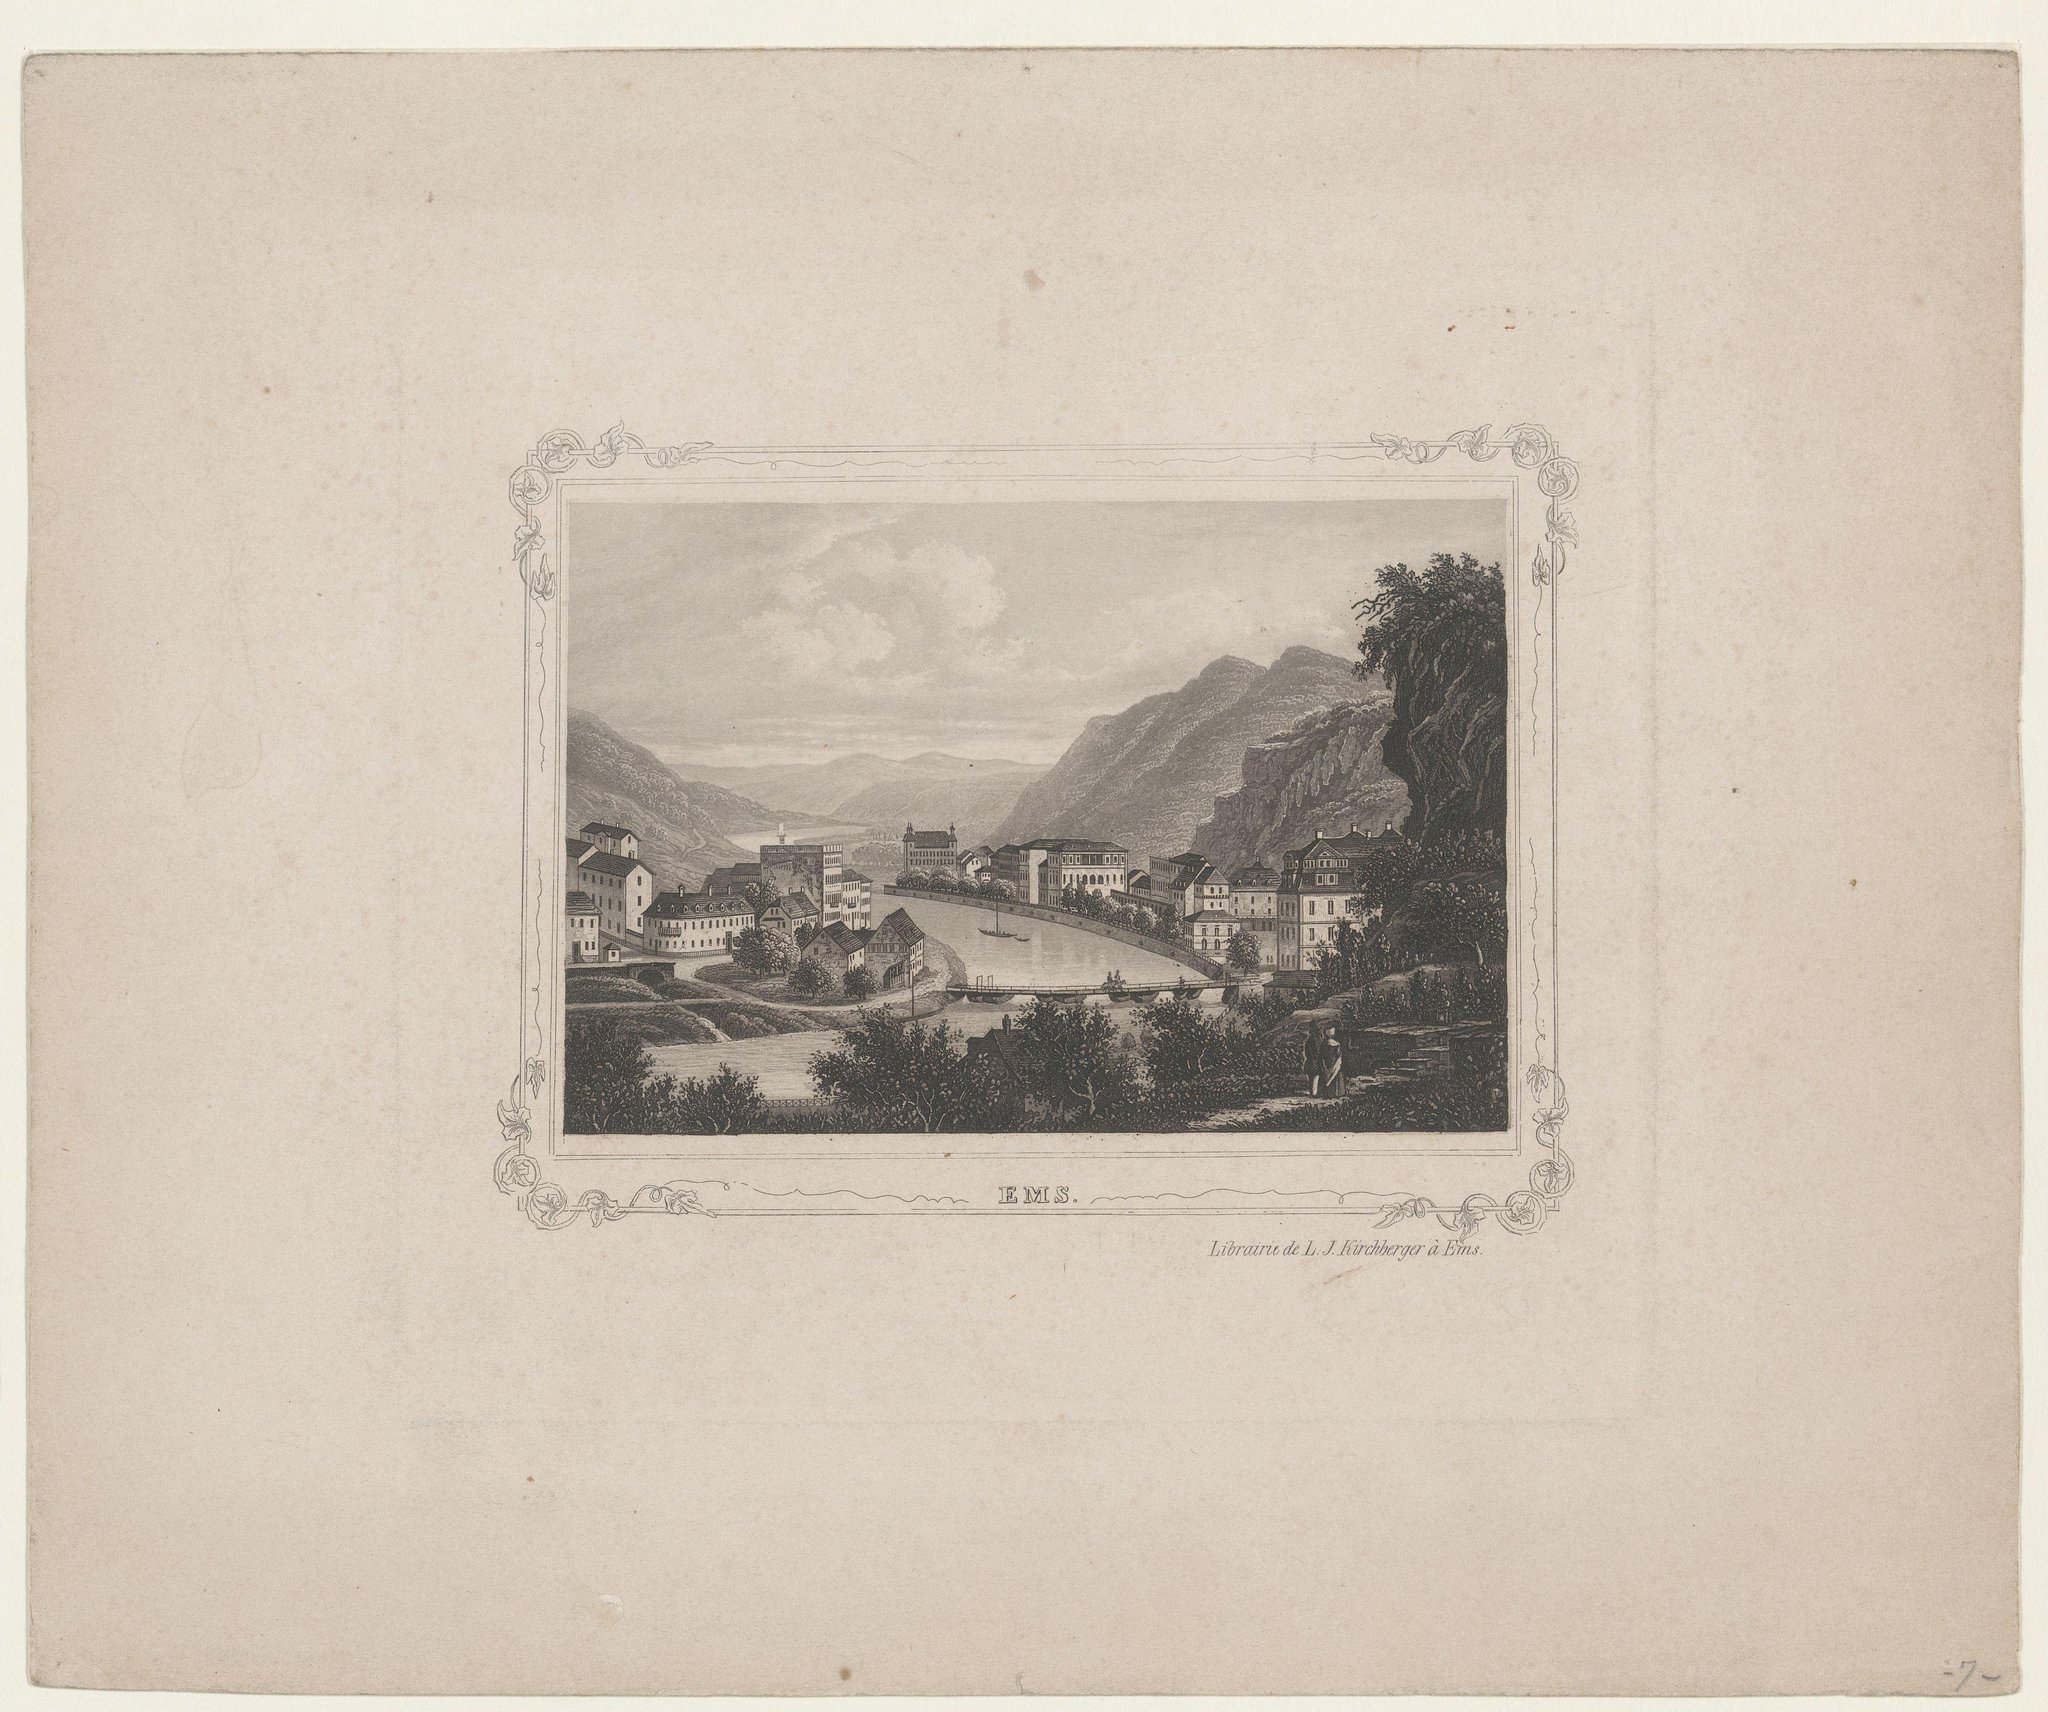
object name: print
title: Ems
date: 1850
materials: paper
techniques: aquatint, etching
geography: bad ems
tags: prospect of village, silhouette of village, river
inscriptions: collector's mark: Lugt 2228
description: Prent ook gebruikt in: Souvenir du Rhin; Album de vues pittoresques. Bad Ems: L.J. Kirchberger, [ca. 1750].